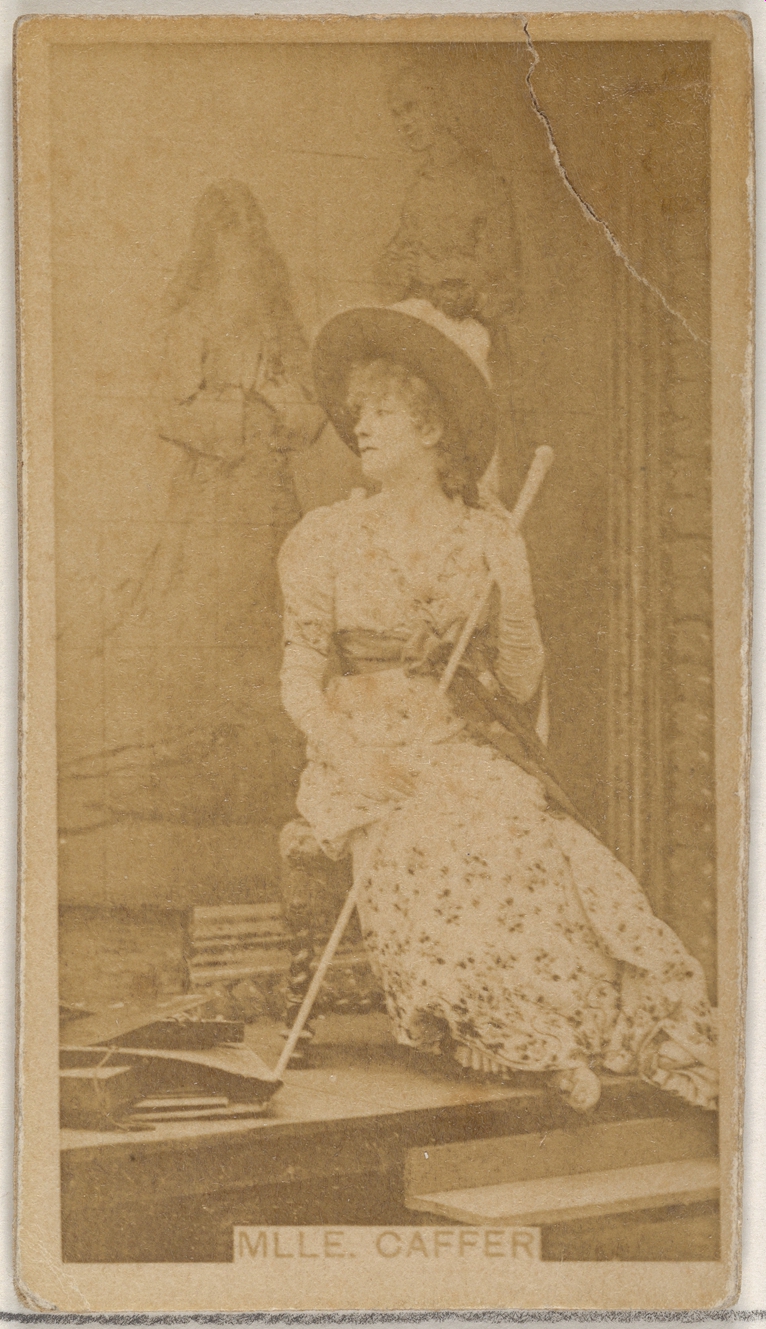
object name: photograph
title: Mlle. Caffer, from the Actors and Actresses series (N45, Type 8) for Virginia Brights Cigarettes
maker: allen & ginter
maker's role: publisher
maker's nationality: american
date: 1888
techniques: albumen silver print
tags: profiles,women,actresses